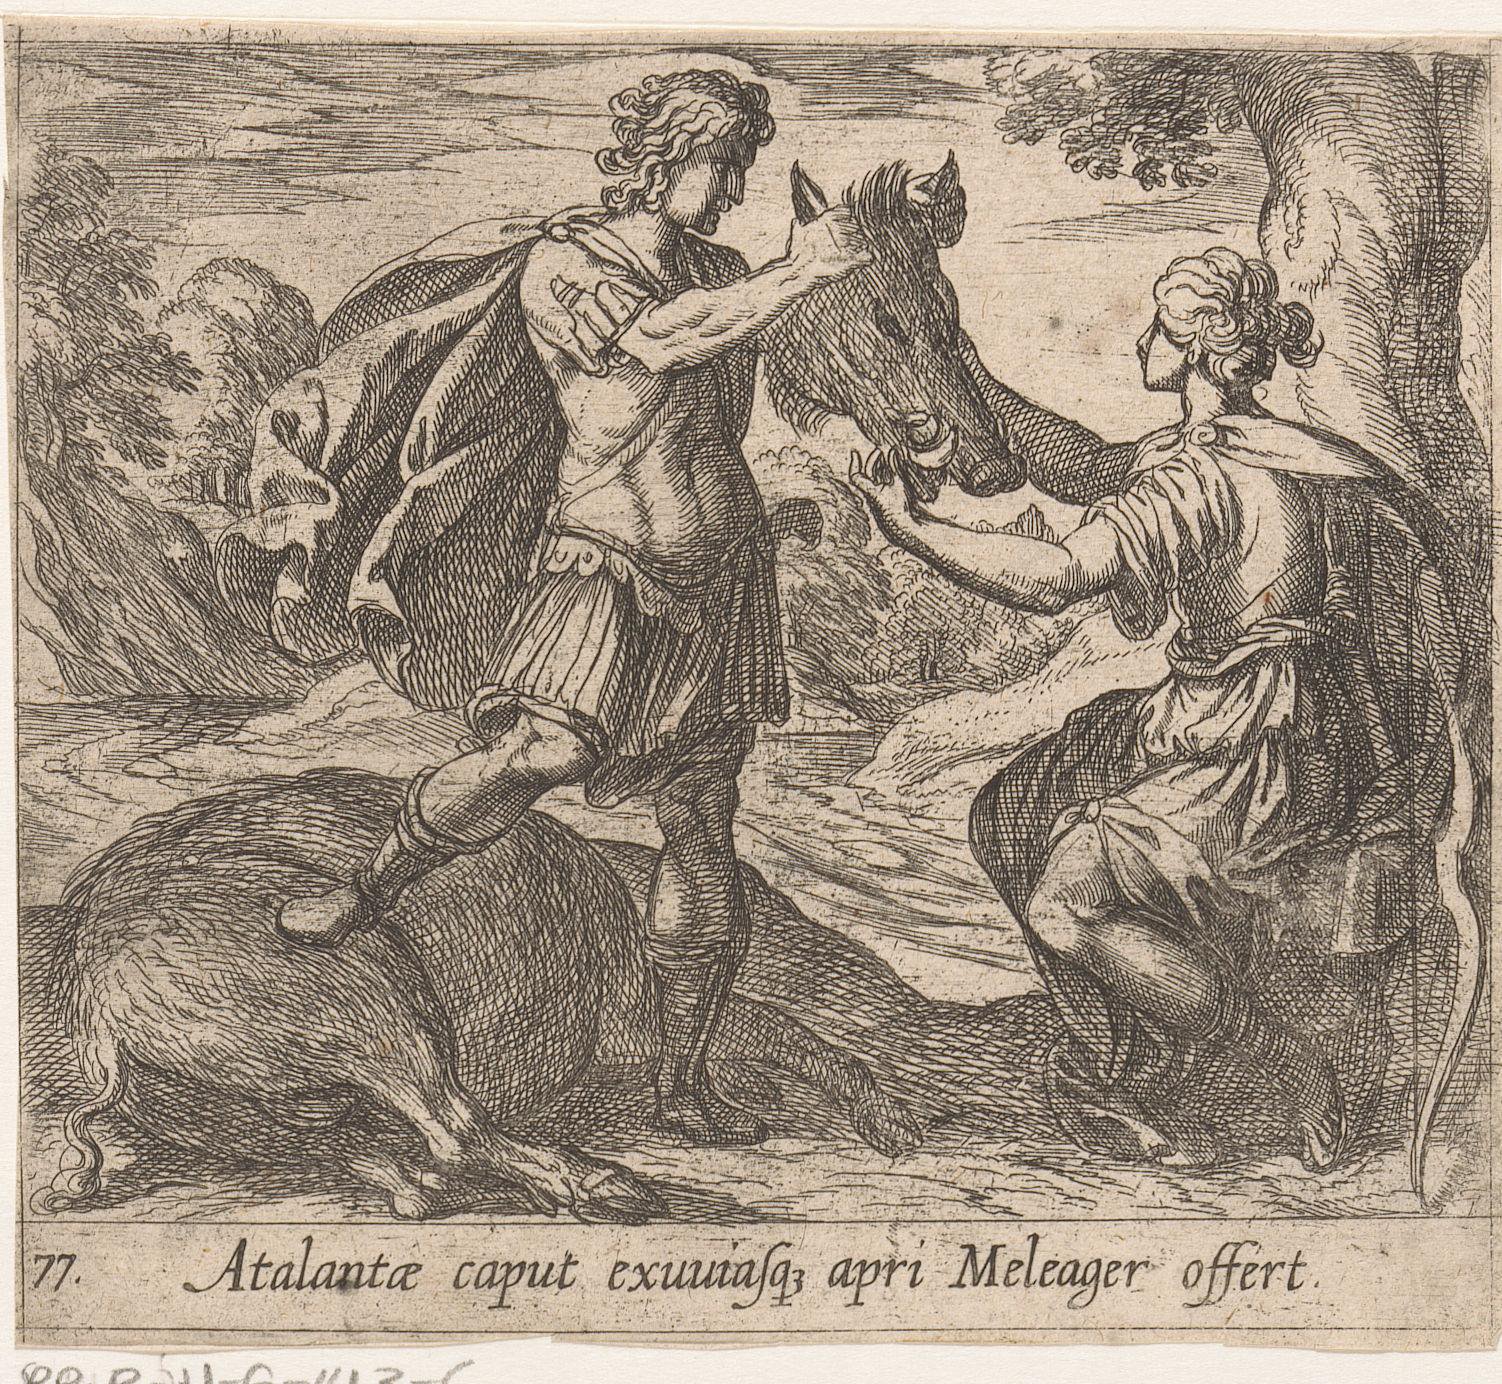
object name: print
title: Metamorphoseon sive transformationum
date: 1606-1638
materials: paper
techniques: etching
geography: amsterdam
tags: meleager gives the head of the boar to atalanta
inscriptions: collector's mark: ‘Hinloopen’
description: Meleager biedt Atalanta de kop van het everzwijn aan, dat ze zojuist samen gedood hebben. Titel in het Latijn in ondermarge.